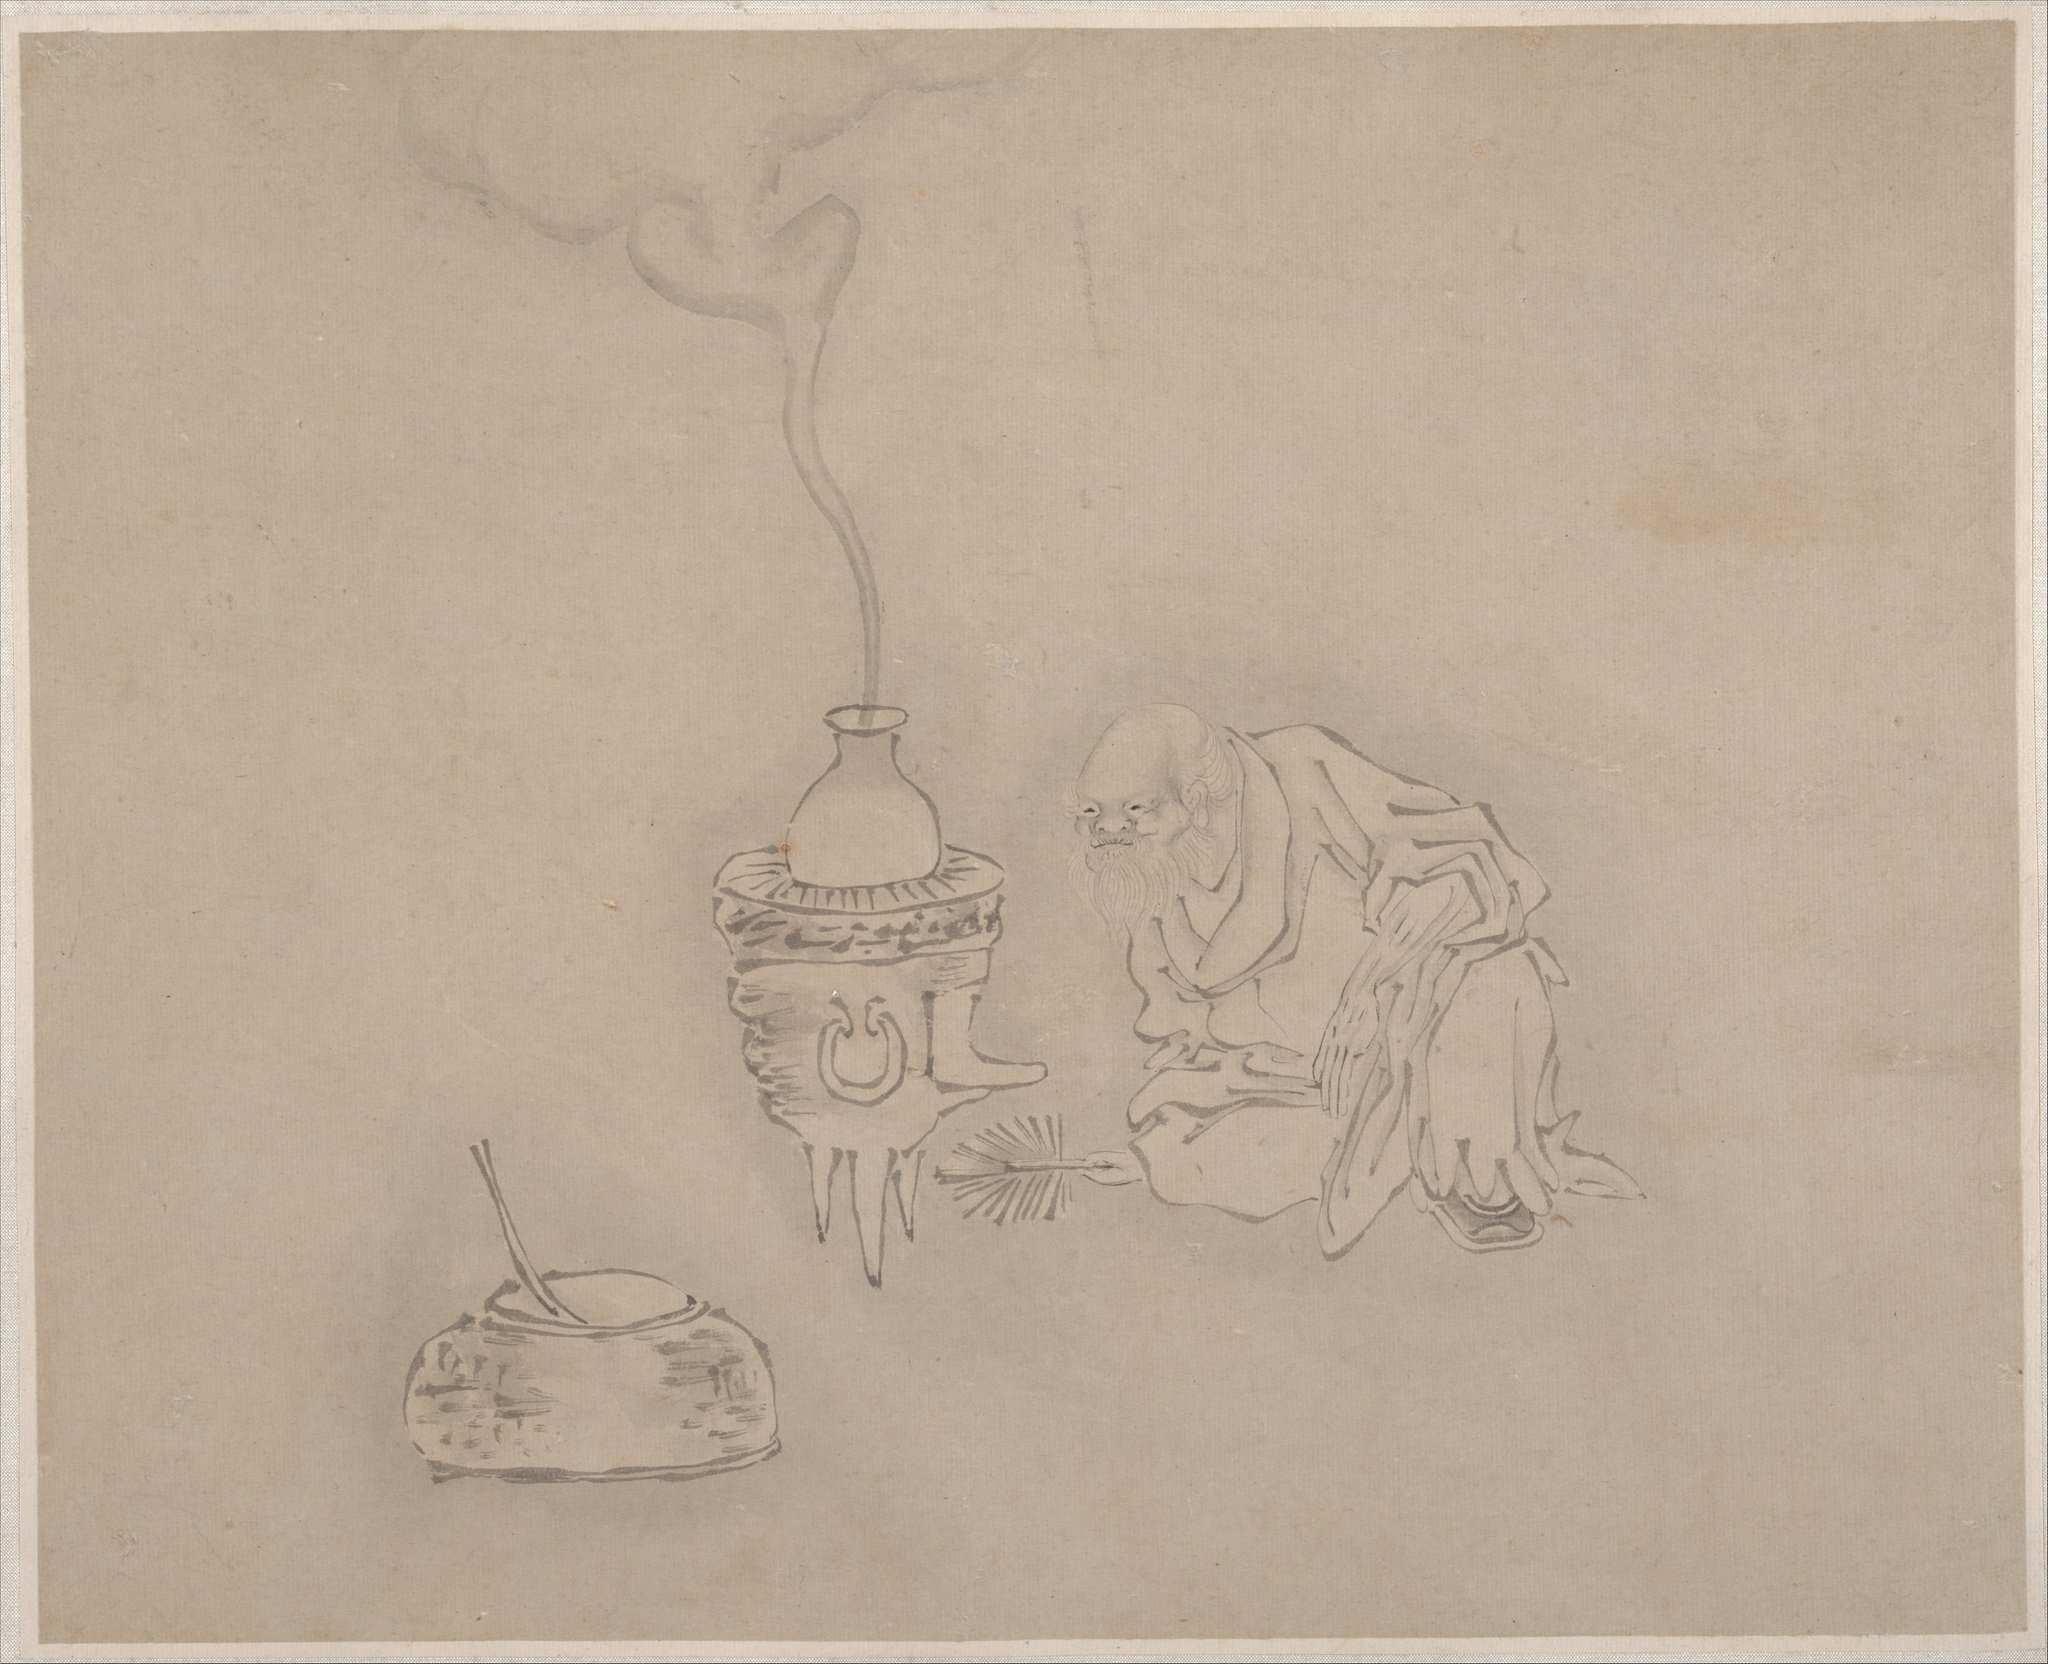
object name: album leaf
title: Painting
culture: chinese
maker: unidentified artist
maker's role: artist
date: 1901-2000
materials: ink, paper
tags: men